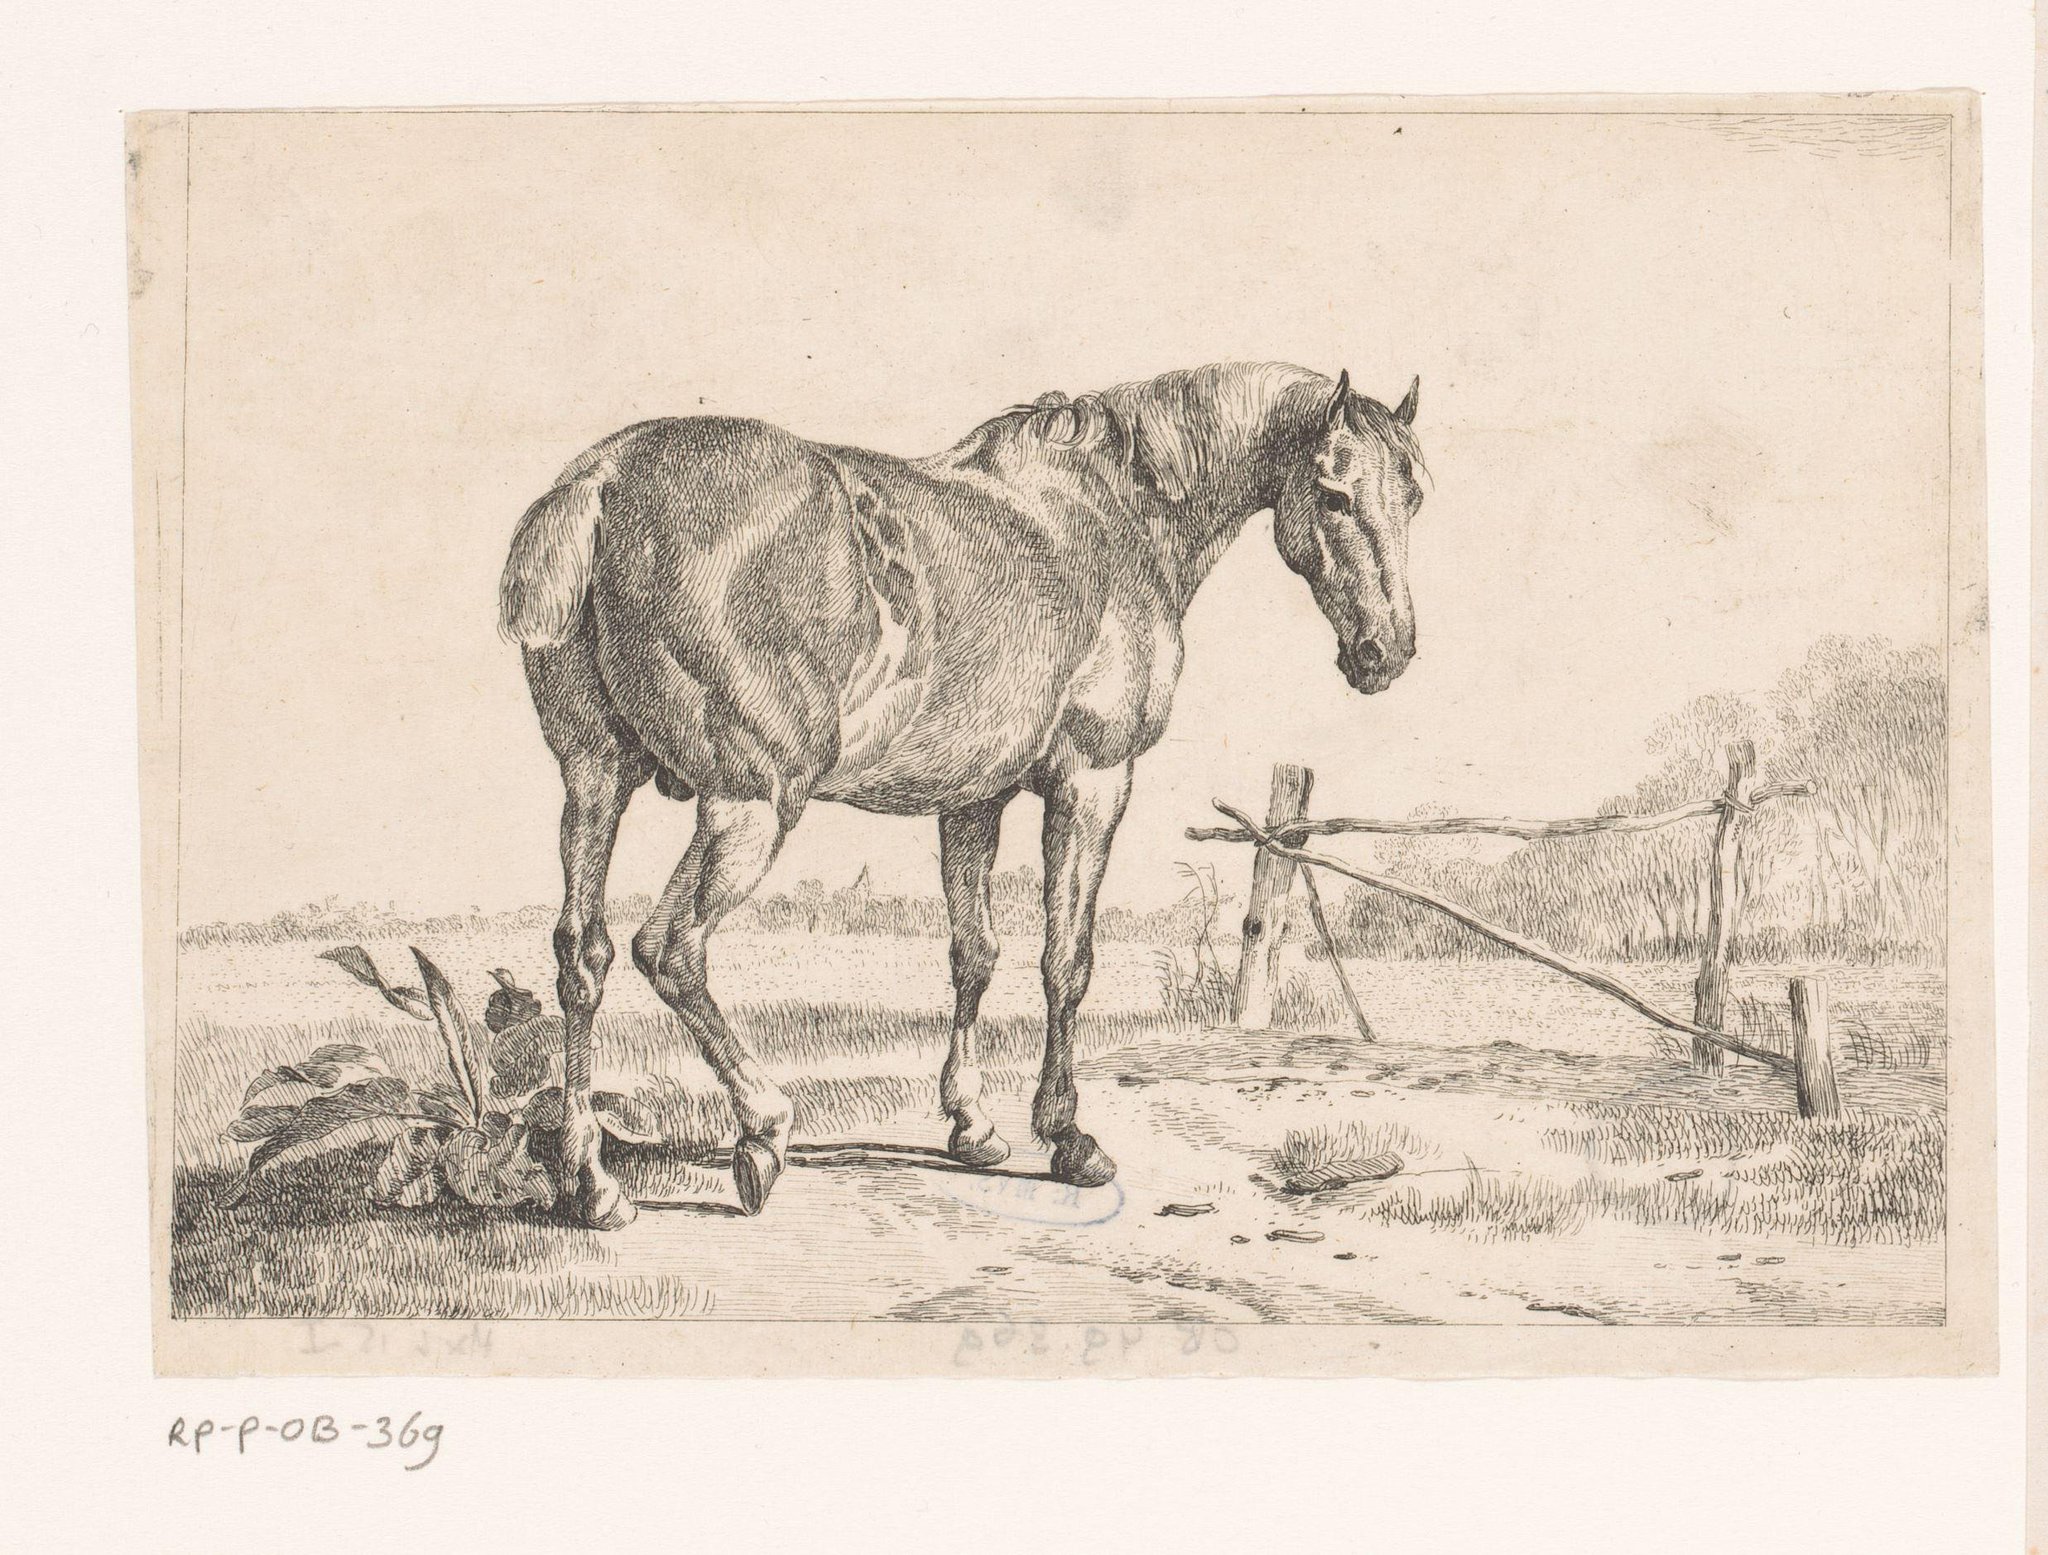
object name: print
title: Landschap met paard bij een hek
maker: auguste herman marie de noter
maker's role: print maker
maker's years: 1806-1838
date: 1831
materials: paper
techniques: etching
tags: landscapes, horse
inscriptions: collector's mark: Lugt 2228